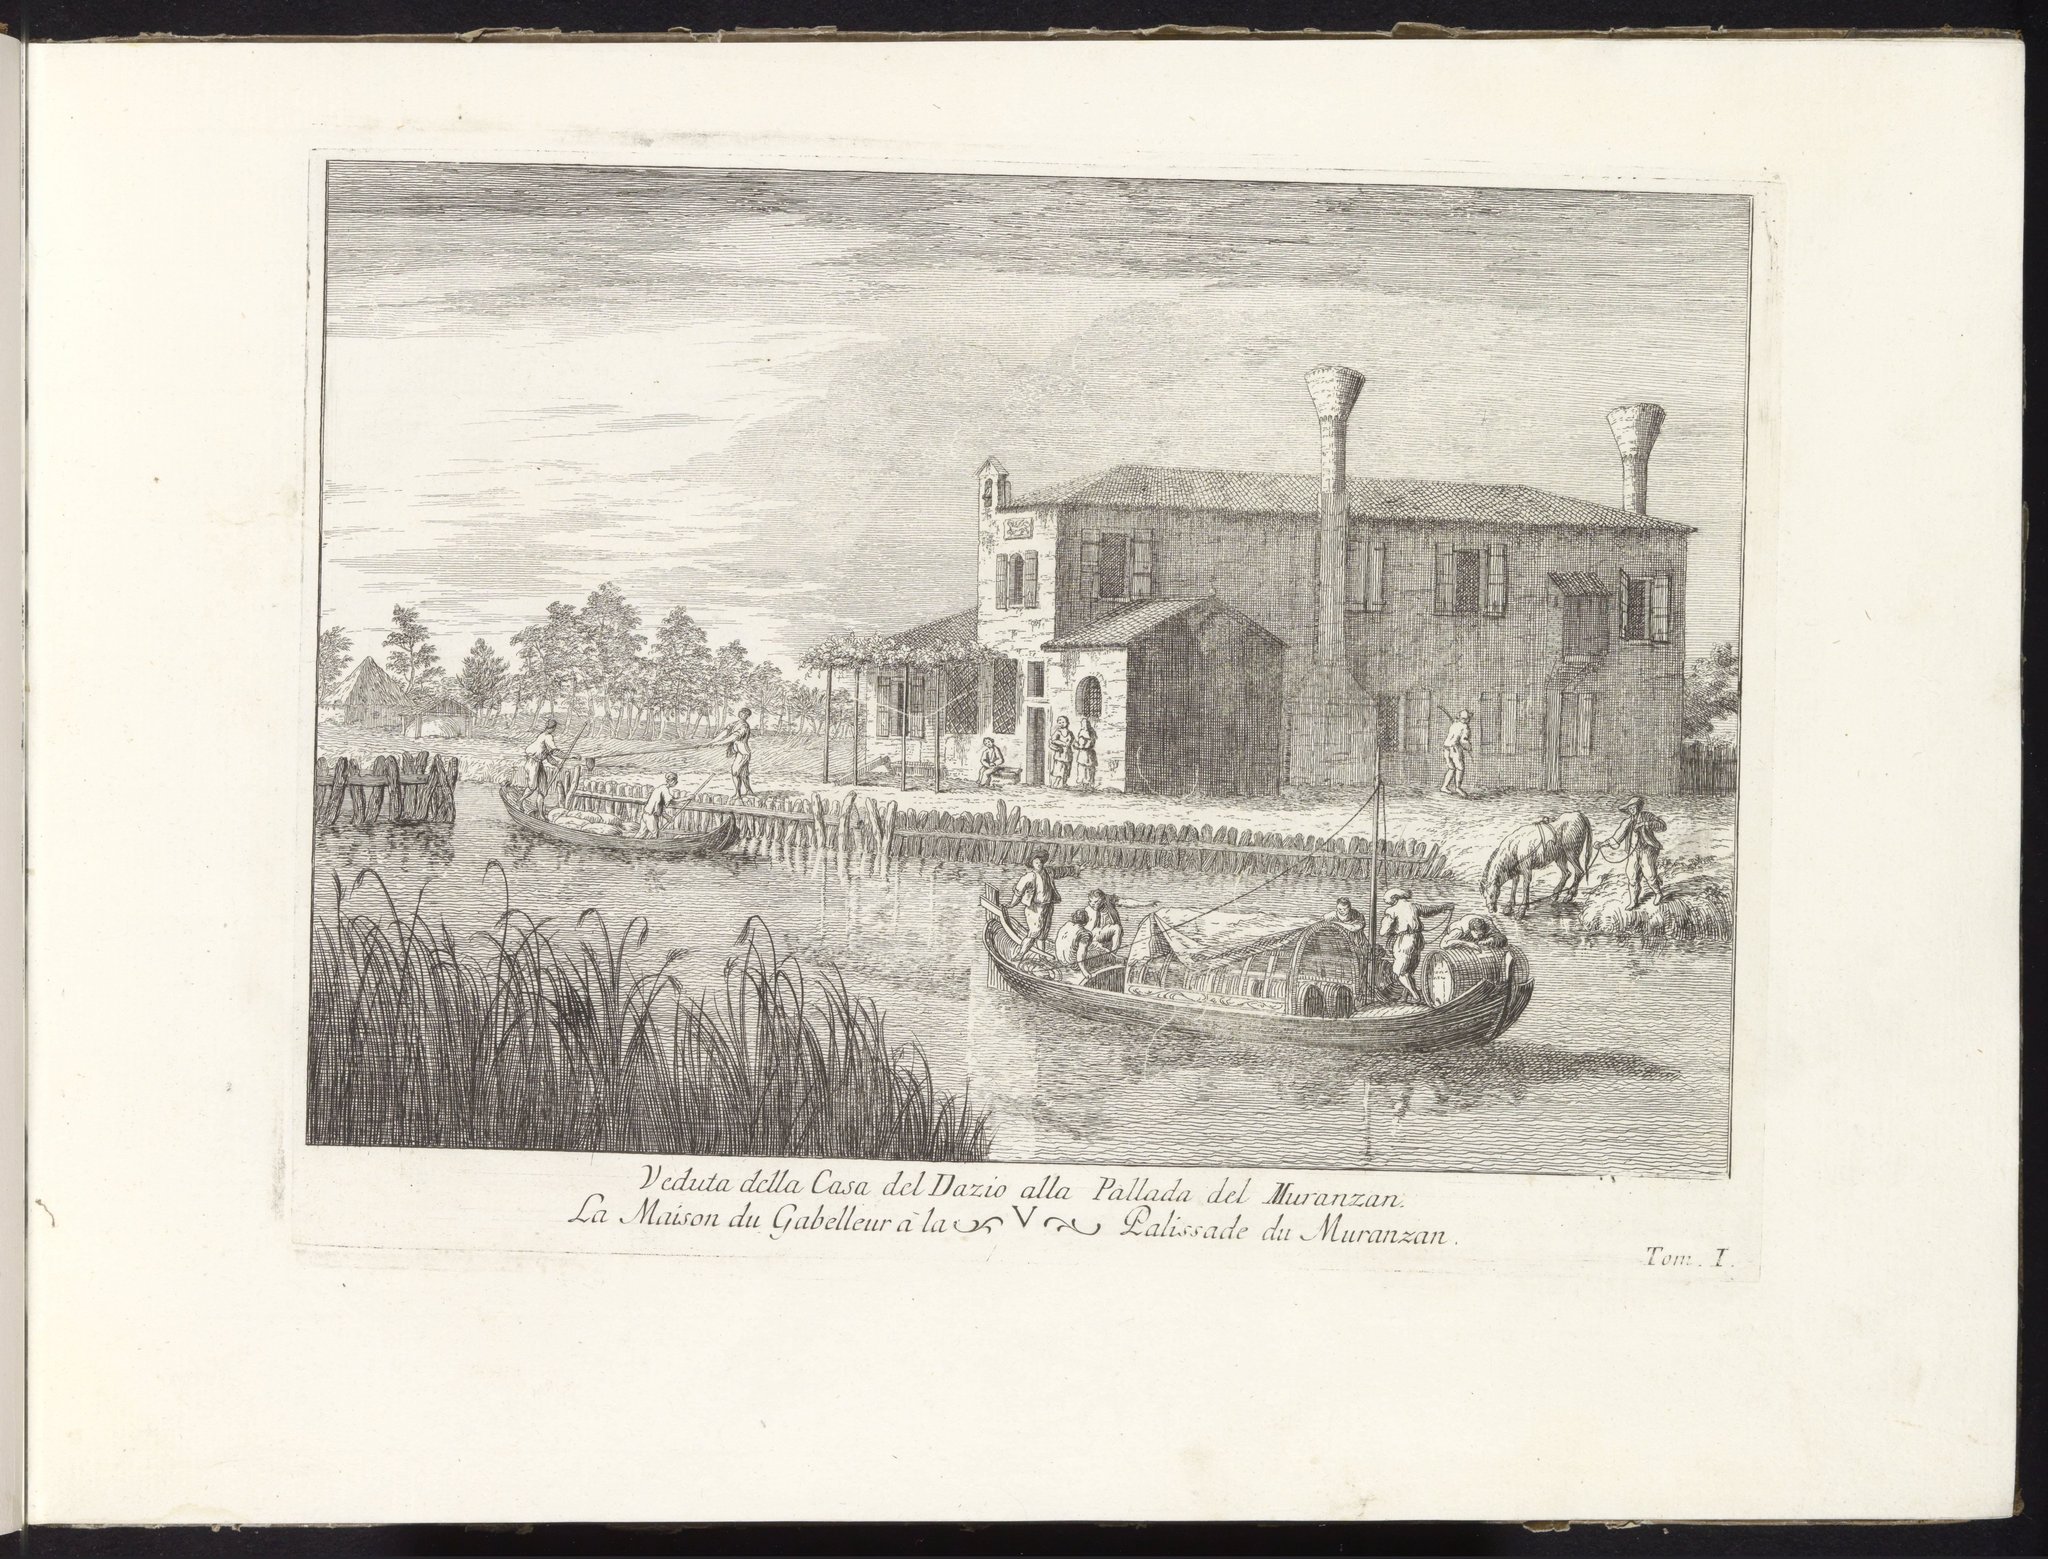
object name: print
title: Gezichten op de rivier de Brenta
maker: giovanni francesco costa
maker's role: draughtsman, painter, print maker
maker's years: -1773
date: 1760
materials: paper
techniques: etching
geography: venice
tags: river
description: Gezicht op een deel van de rivier de Brenta dat is afgezet met houten palen. Langs de rivier staat Casa del Dazio. Genummerd midden onder: V en rechtsonder: Tom: I. Deze prent maakt deel uit van een album.